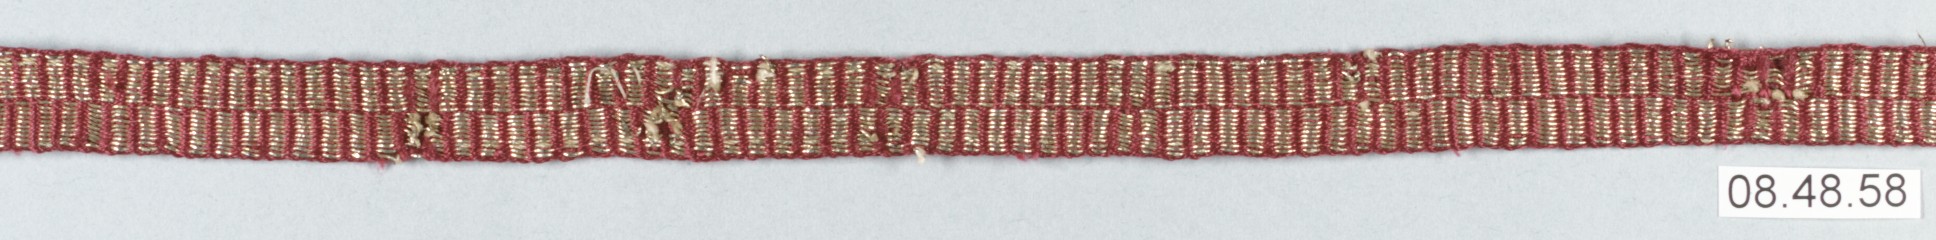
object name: galloon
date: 1701-1733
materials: silk